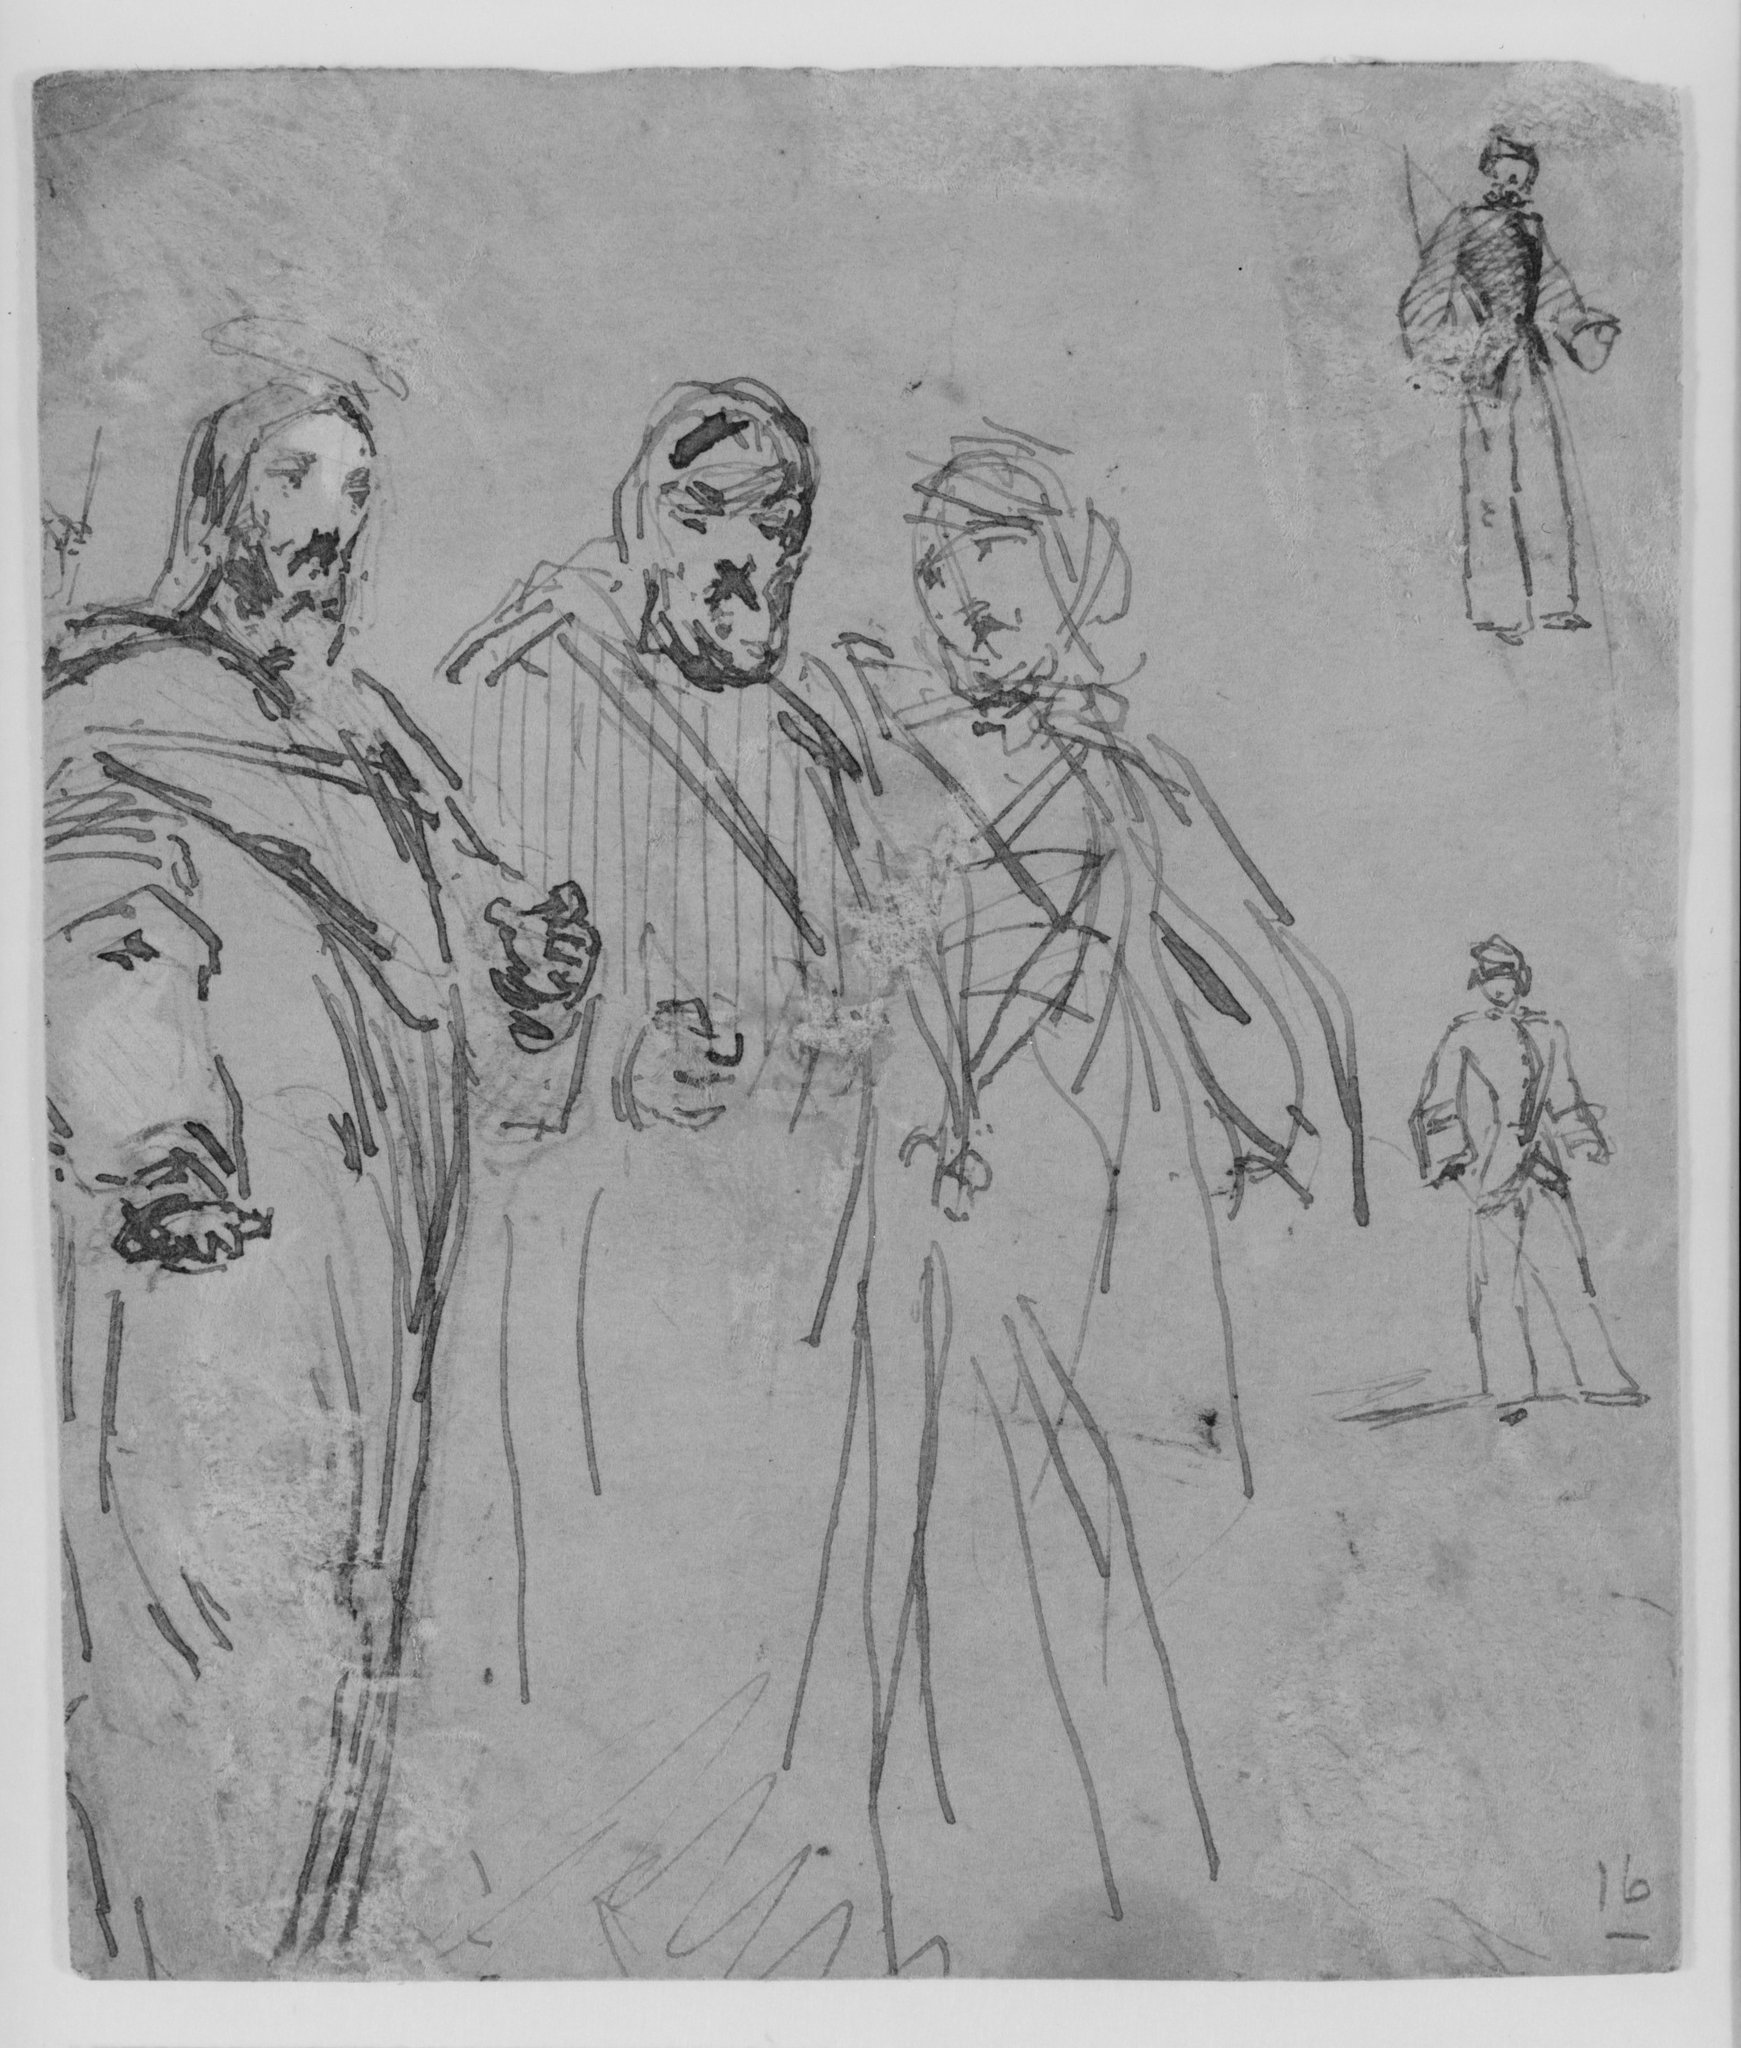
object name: drawing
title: Christ and Two Figures (from Sketchbook)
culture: american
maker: james mcneill whistler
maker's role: artist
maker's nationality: american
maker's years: 1834-1903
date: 1854-1855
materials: ink, paper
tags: men,christ